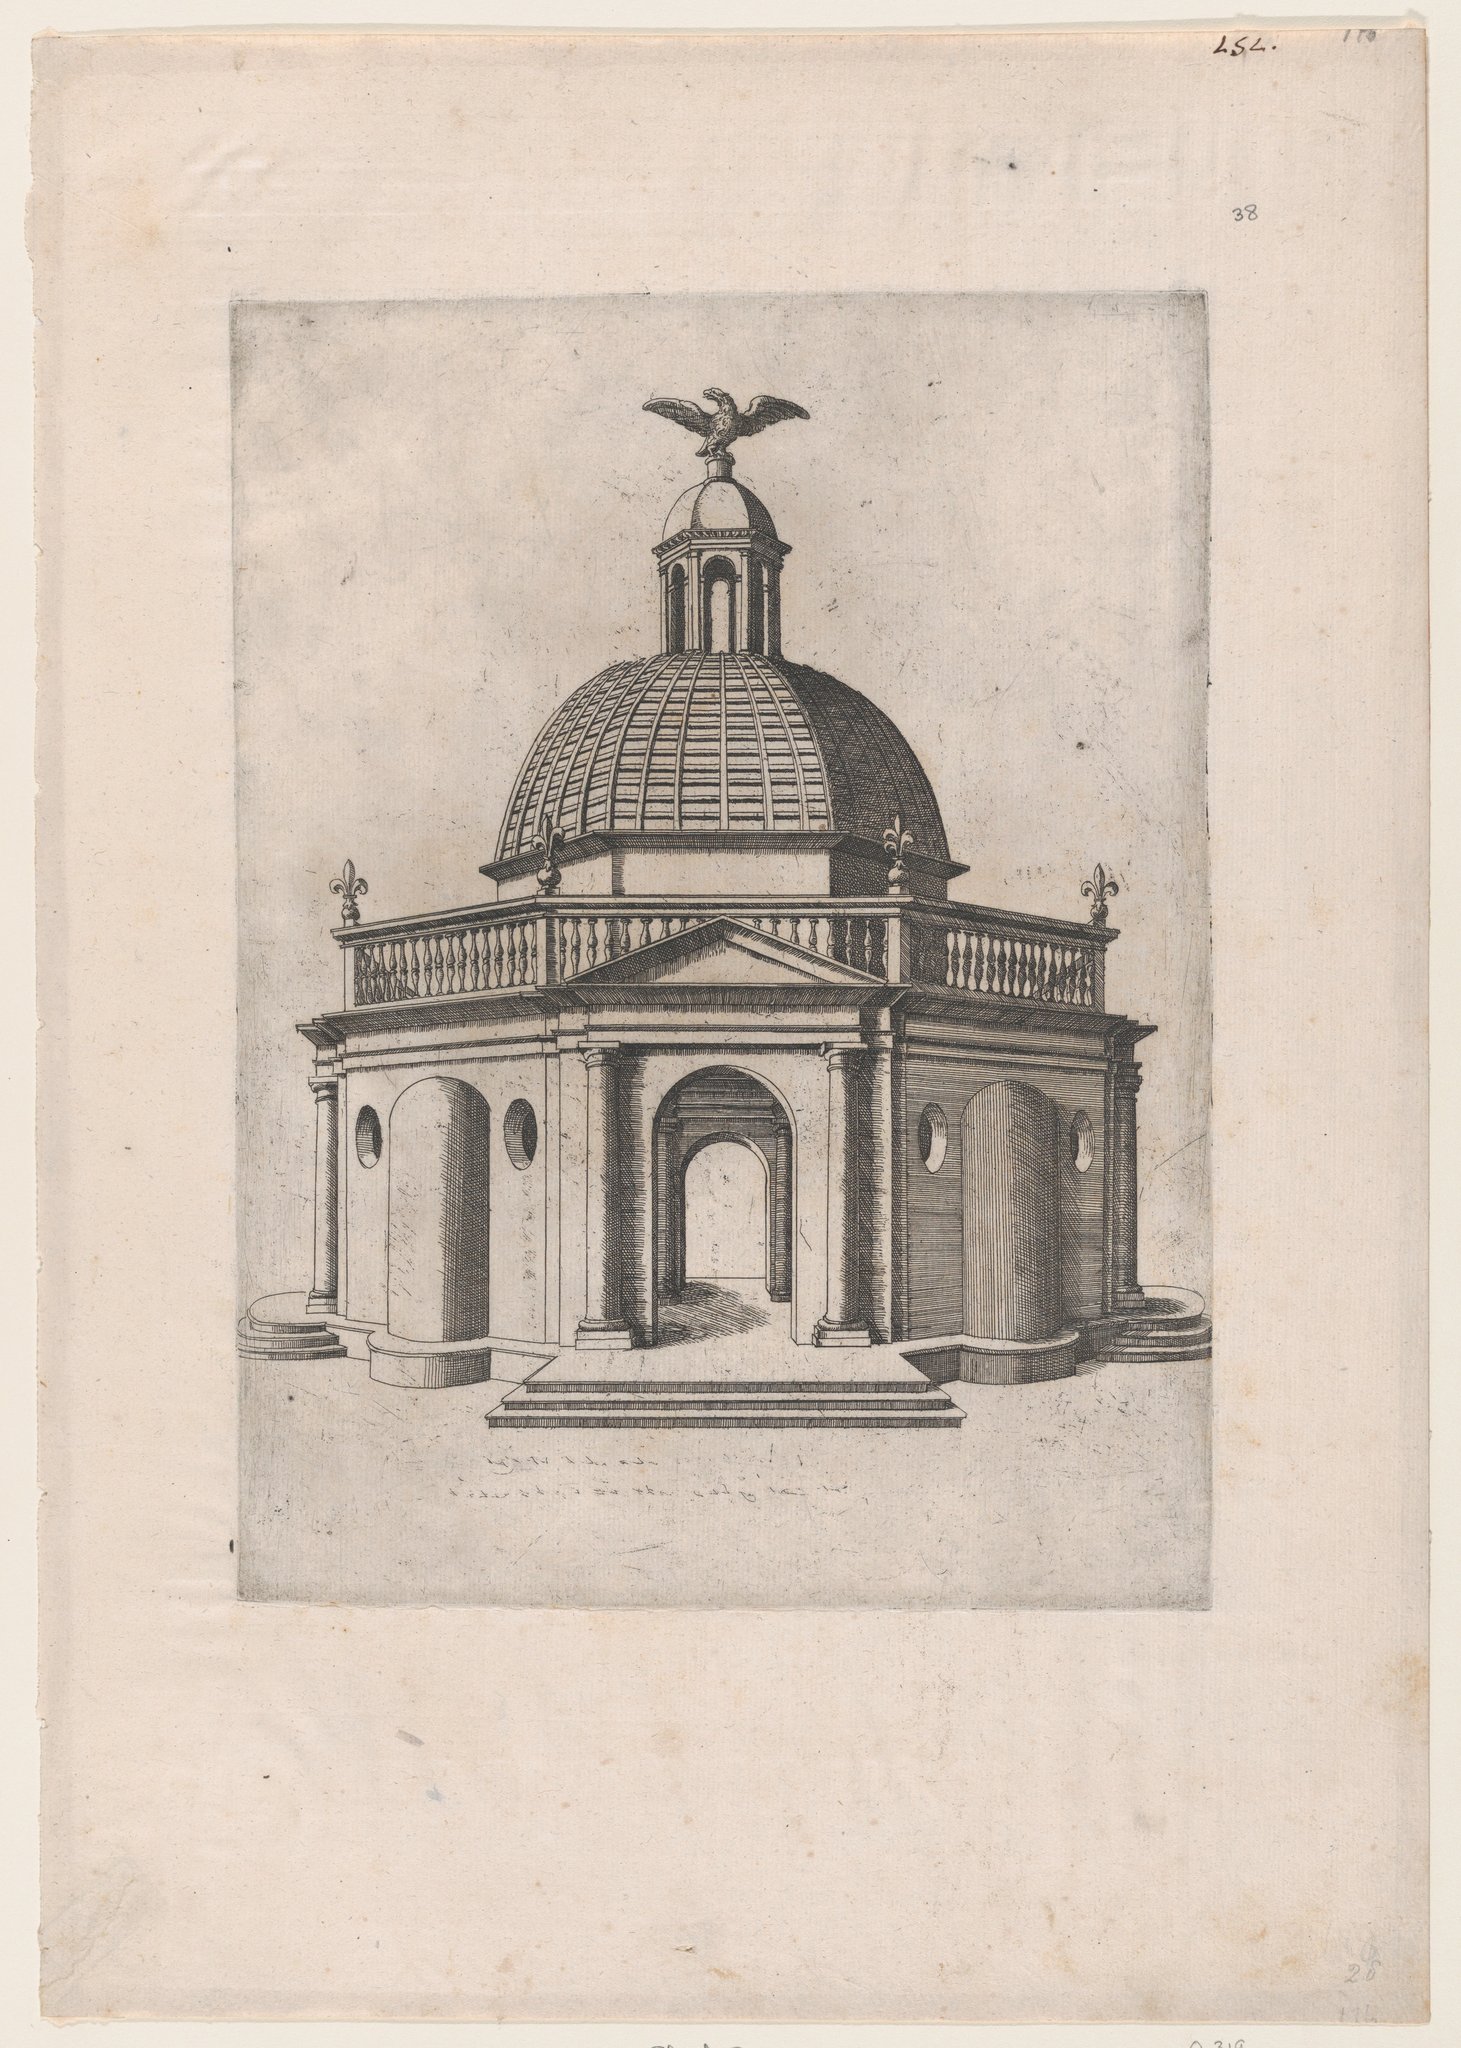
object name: print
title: Octagonal Temple with a dome, surmounted by a domed turret, crowned with an eagle, from "Speculum Romanae Magnificentiae"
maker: Anonymous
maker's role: artist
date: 1501-1600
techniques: etching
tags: architecture,temples,rome